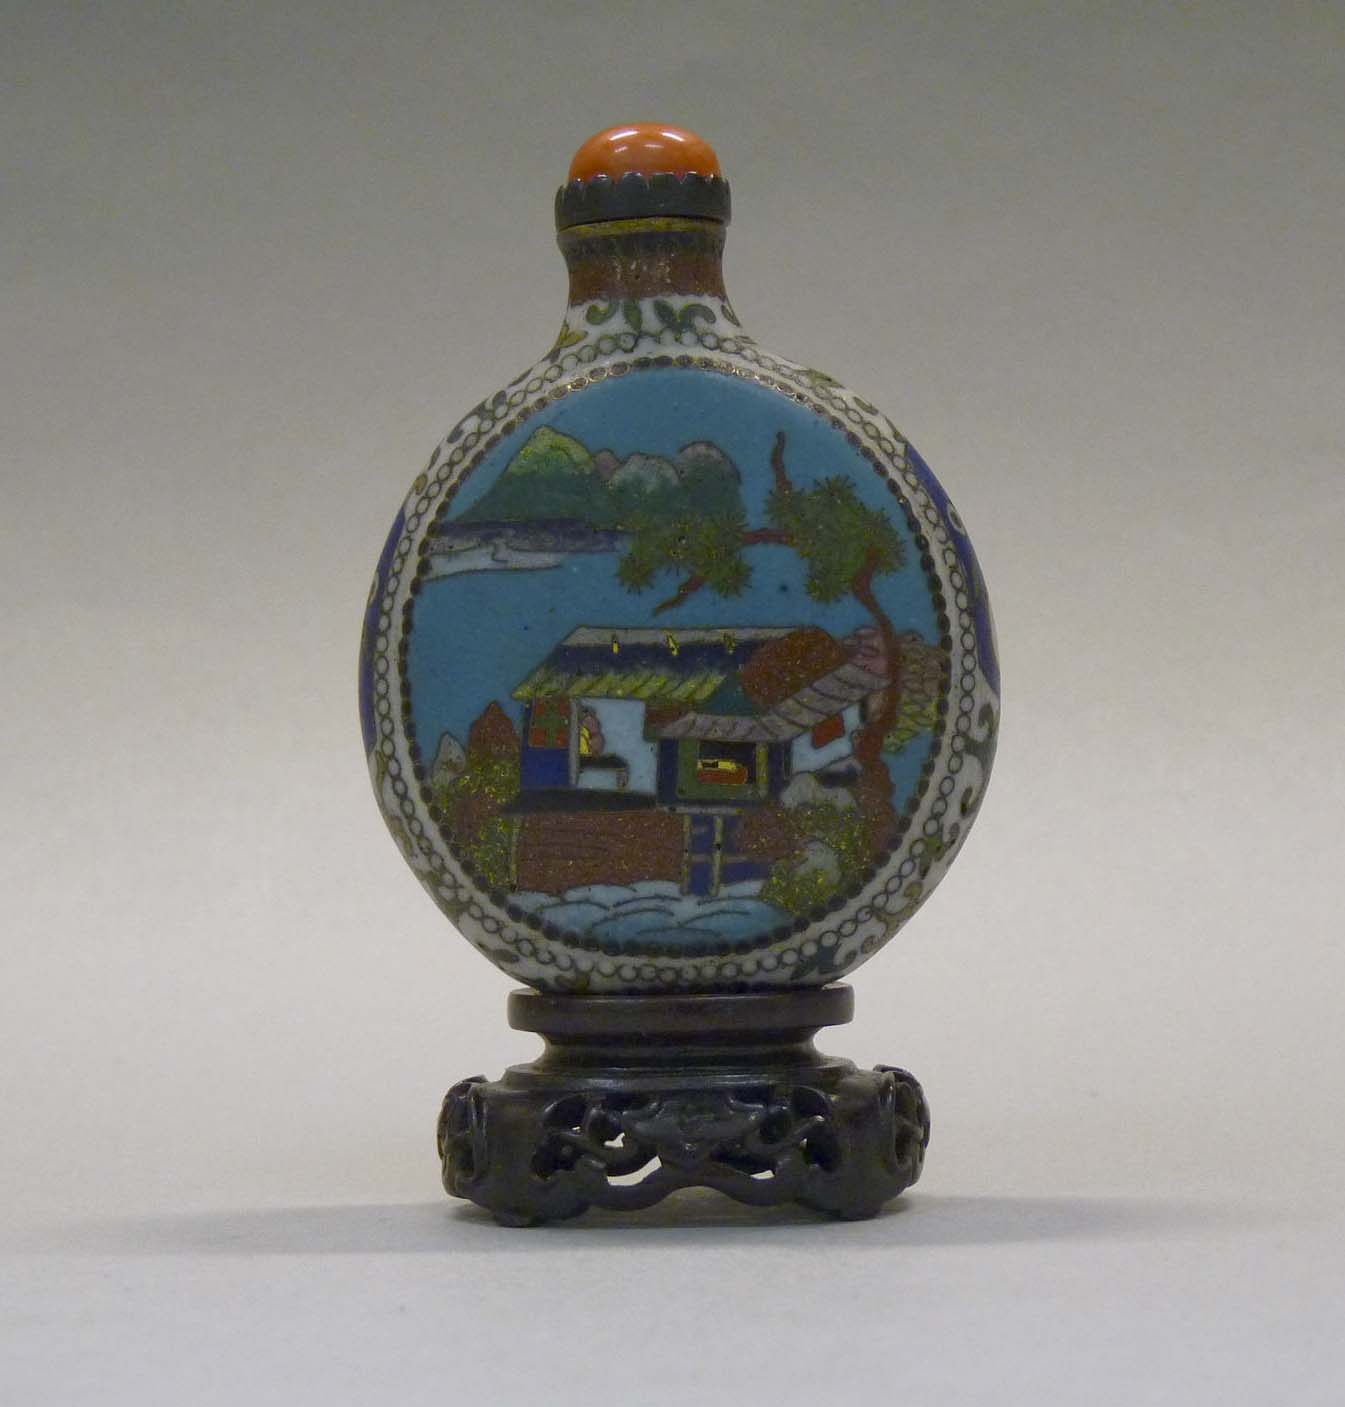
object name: snuff bottle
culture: chinese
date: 1701-1800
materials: coral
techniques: enamel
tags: houses